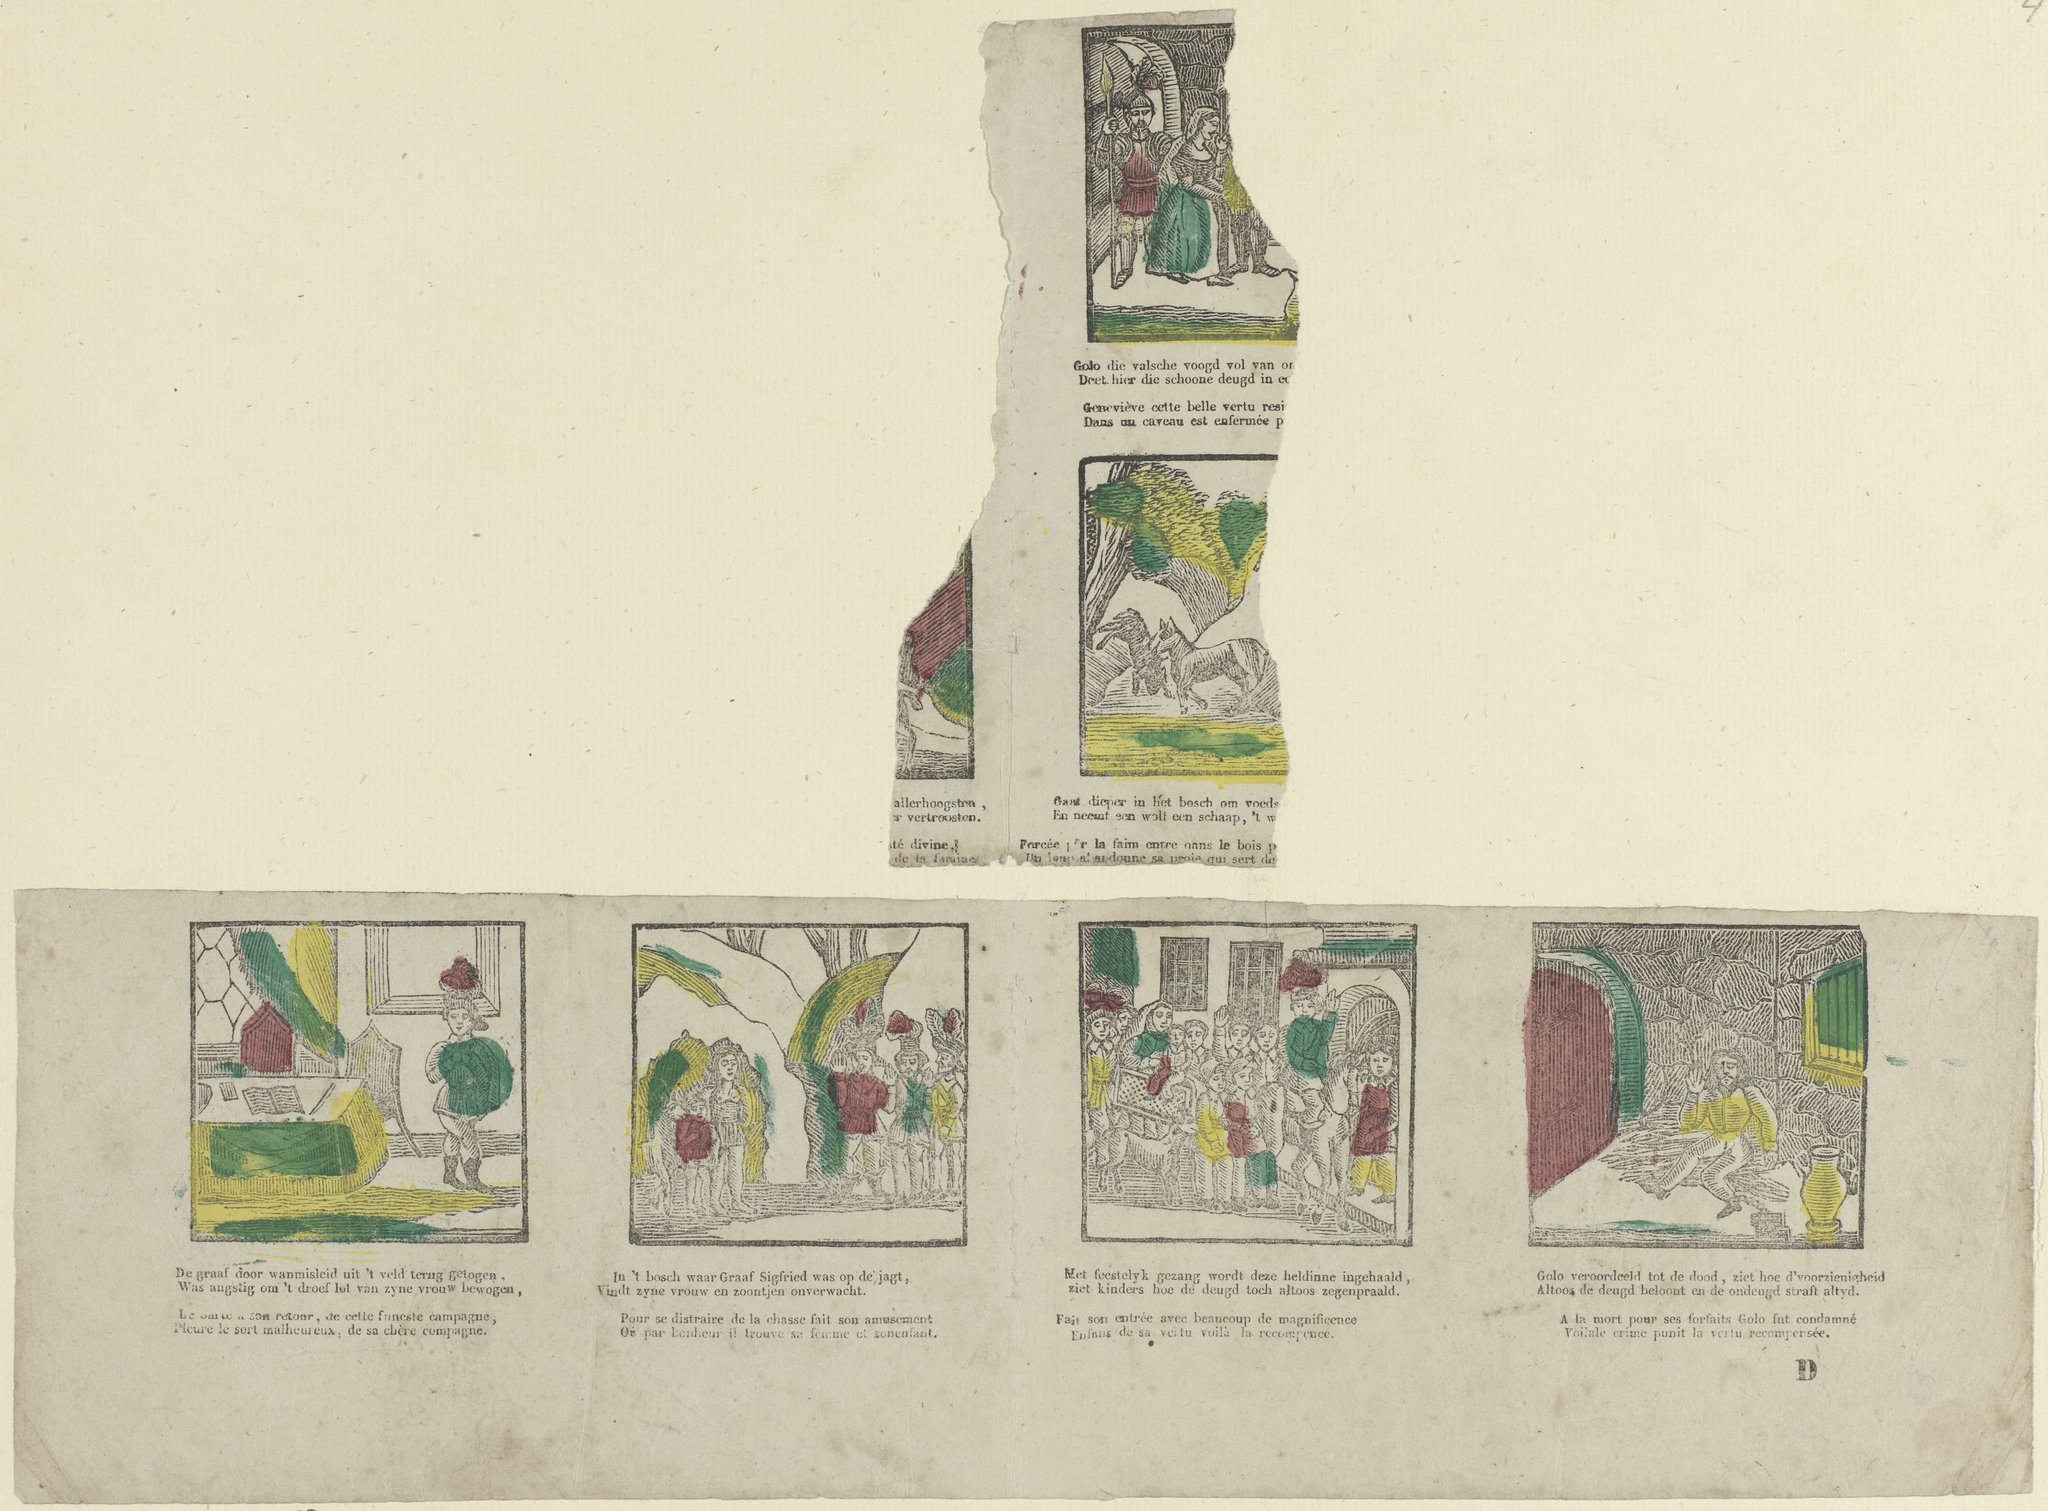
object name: popular print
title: Heylige Génovéva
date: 1842-1856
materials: paper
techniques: colour, letterpress printing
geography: liège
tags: genoveva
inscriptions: collector's mark: Lugt 2760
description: Twee fragmenten van een volksprent met voorstellingen uit het leven van Genoveva van Brabant.